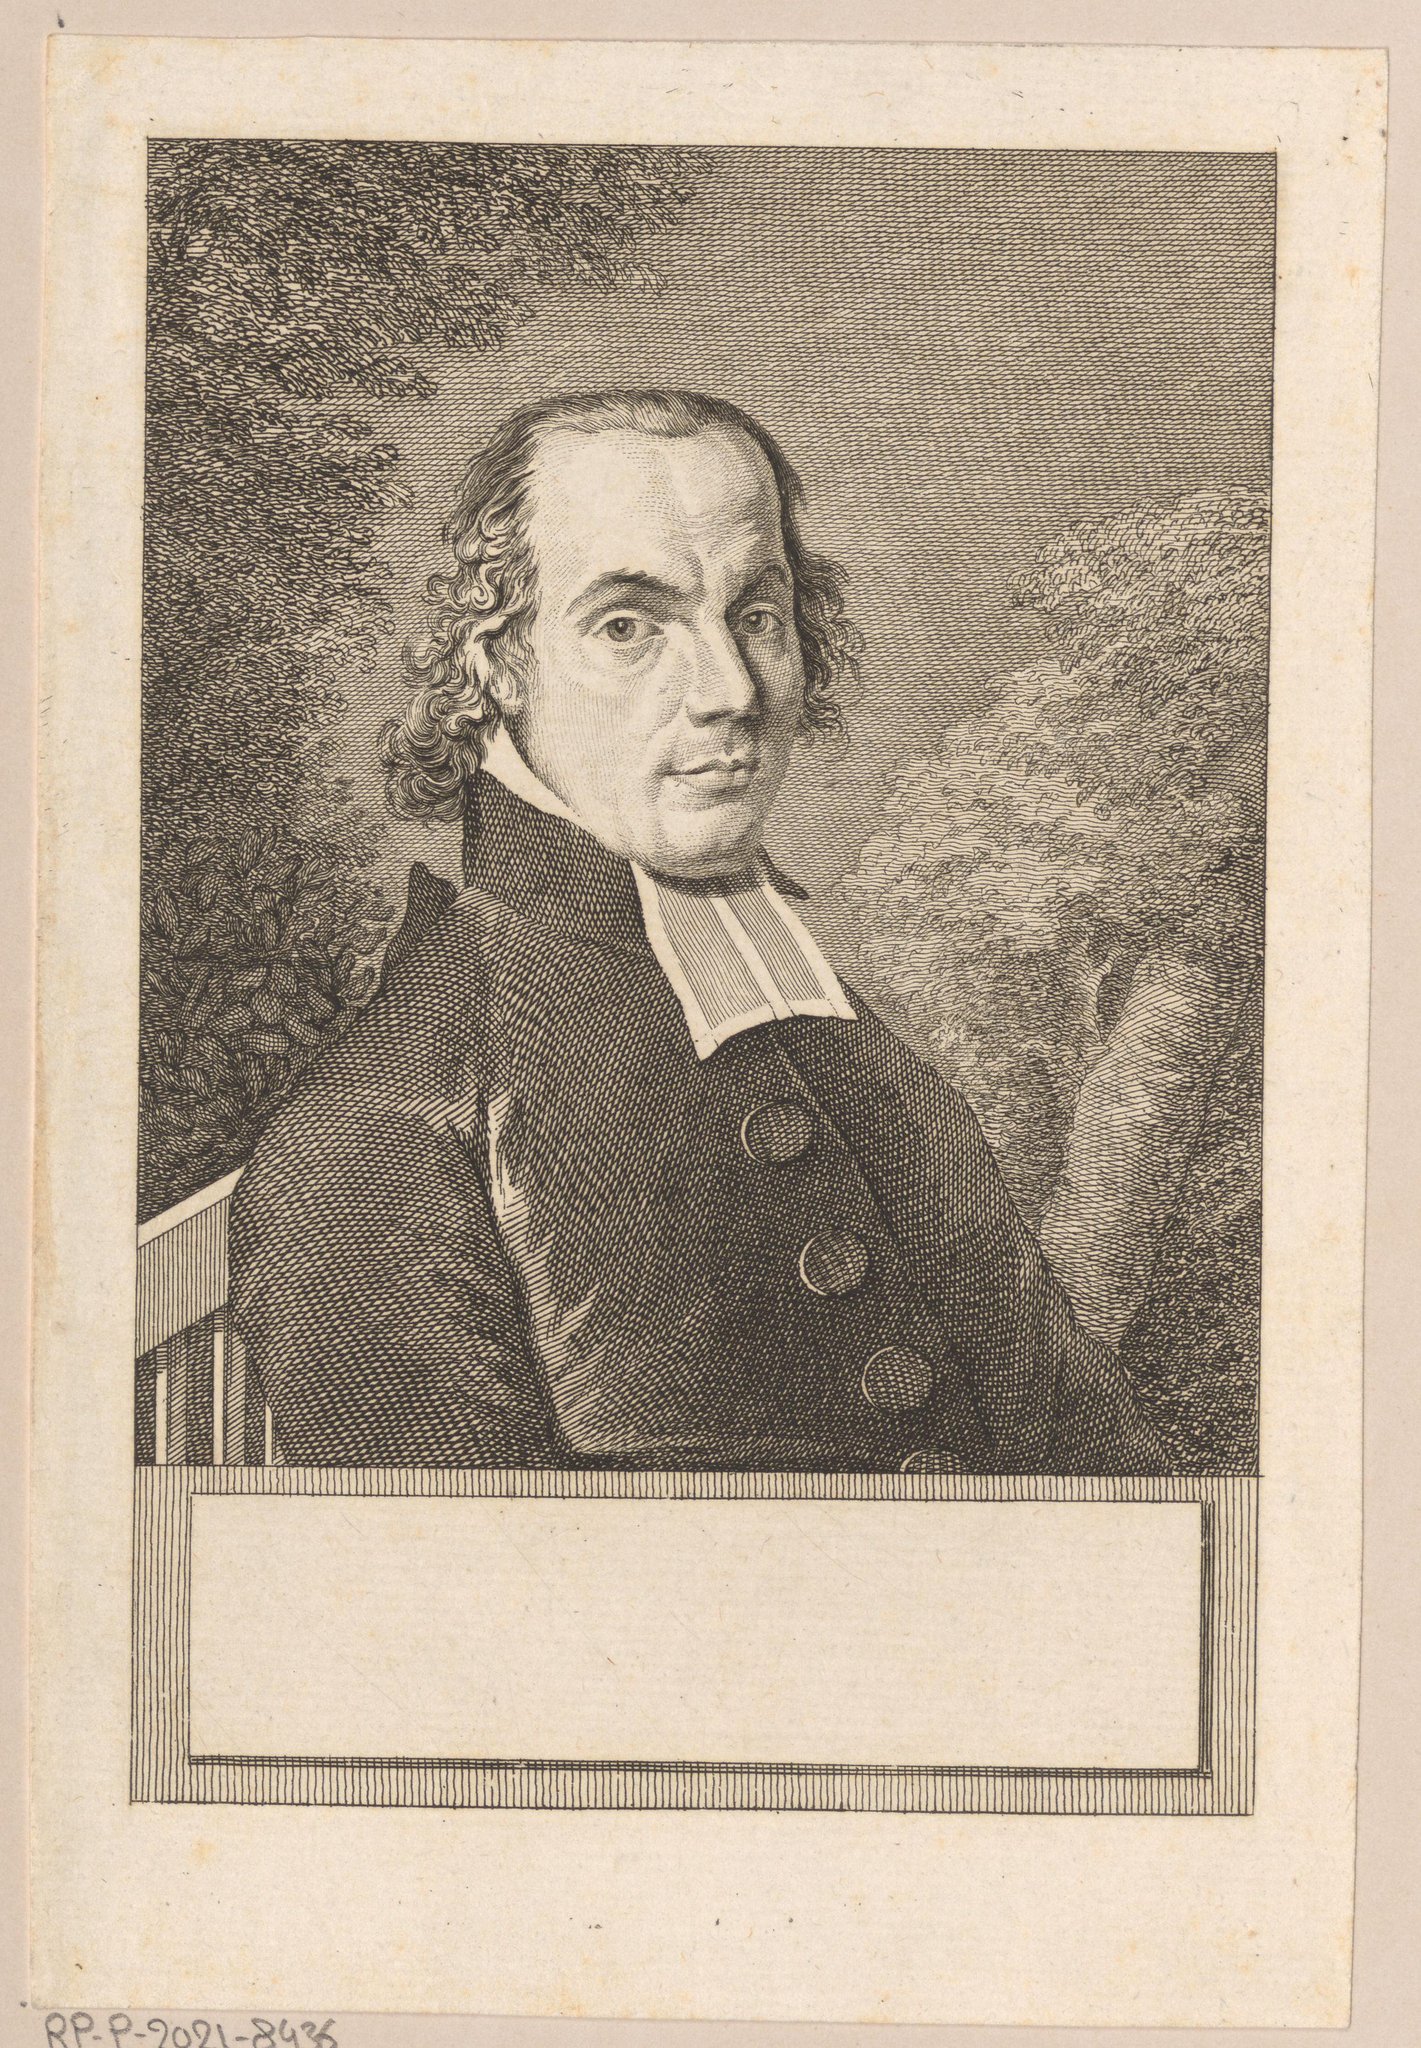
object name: print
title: Portret van Jan van der Roest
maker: Anonymous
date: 1775-1849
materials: paper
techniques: engraving, etching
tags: haarlem, trees, historical persons